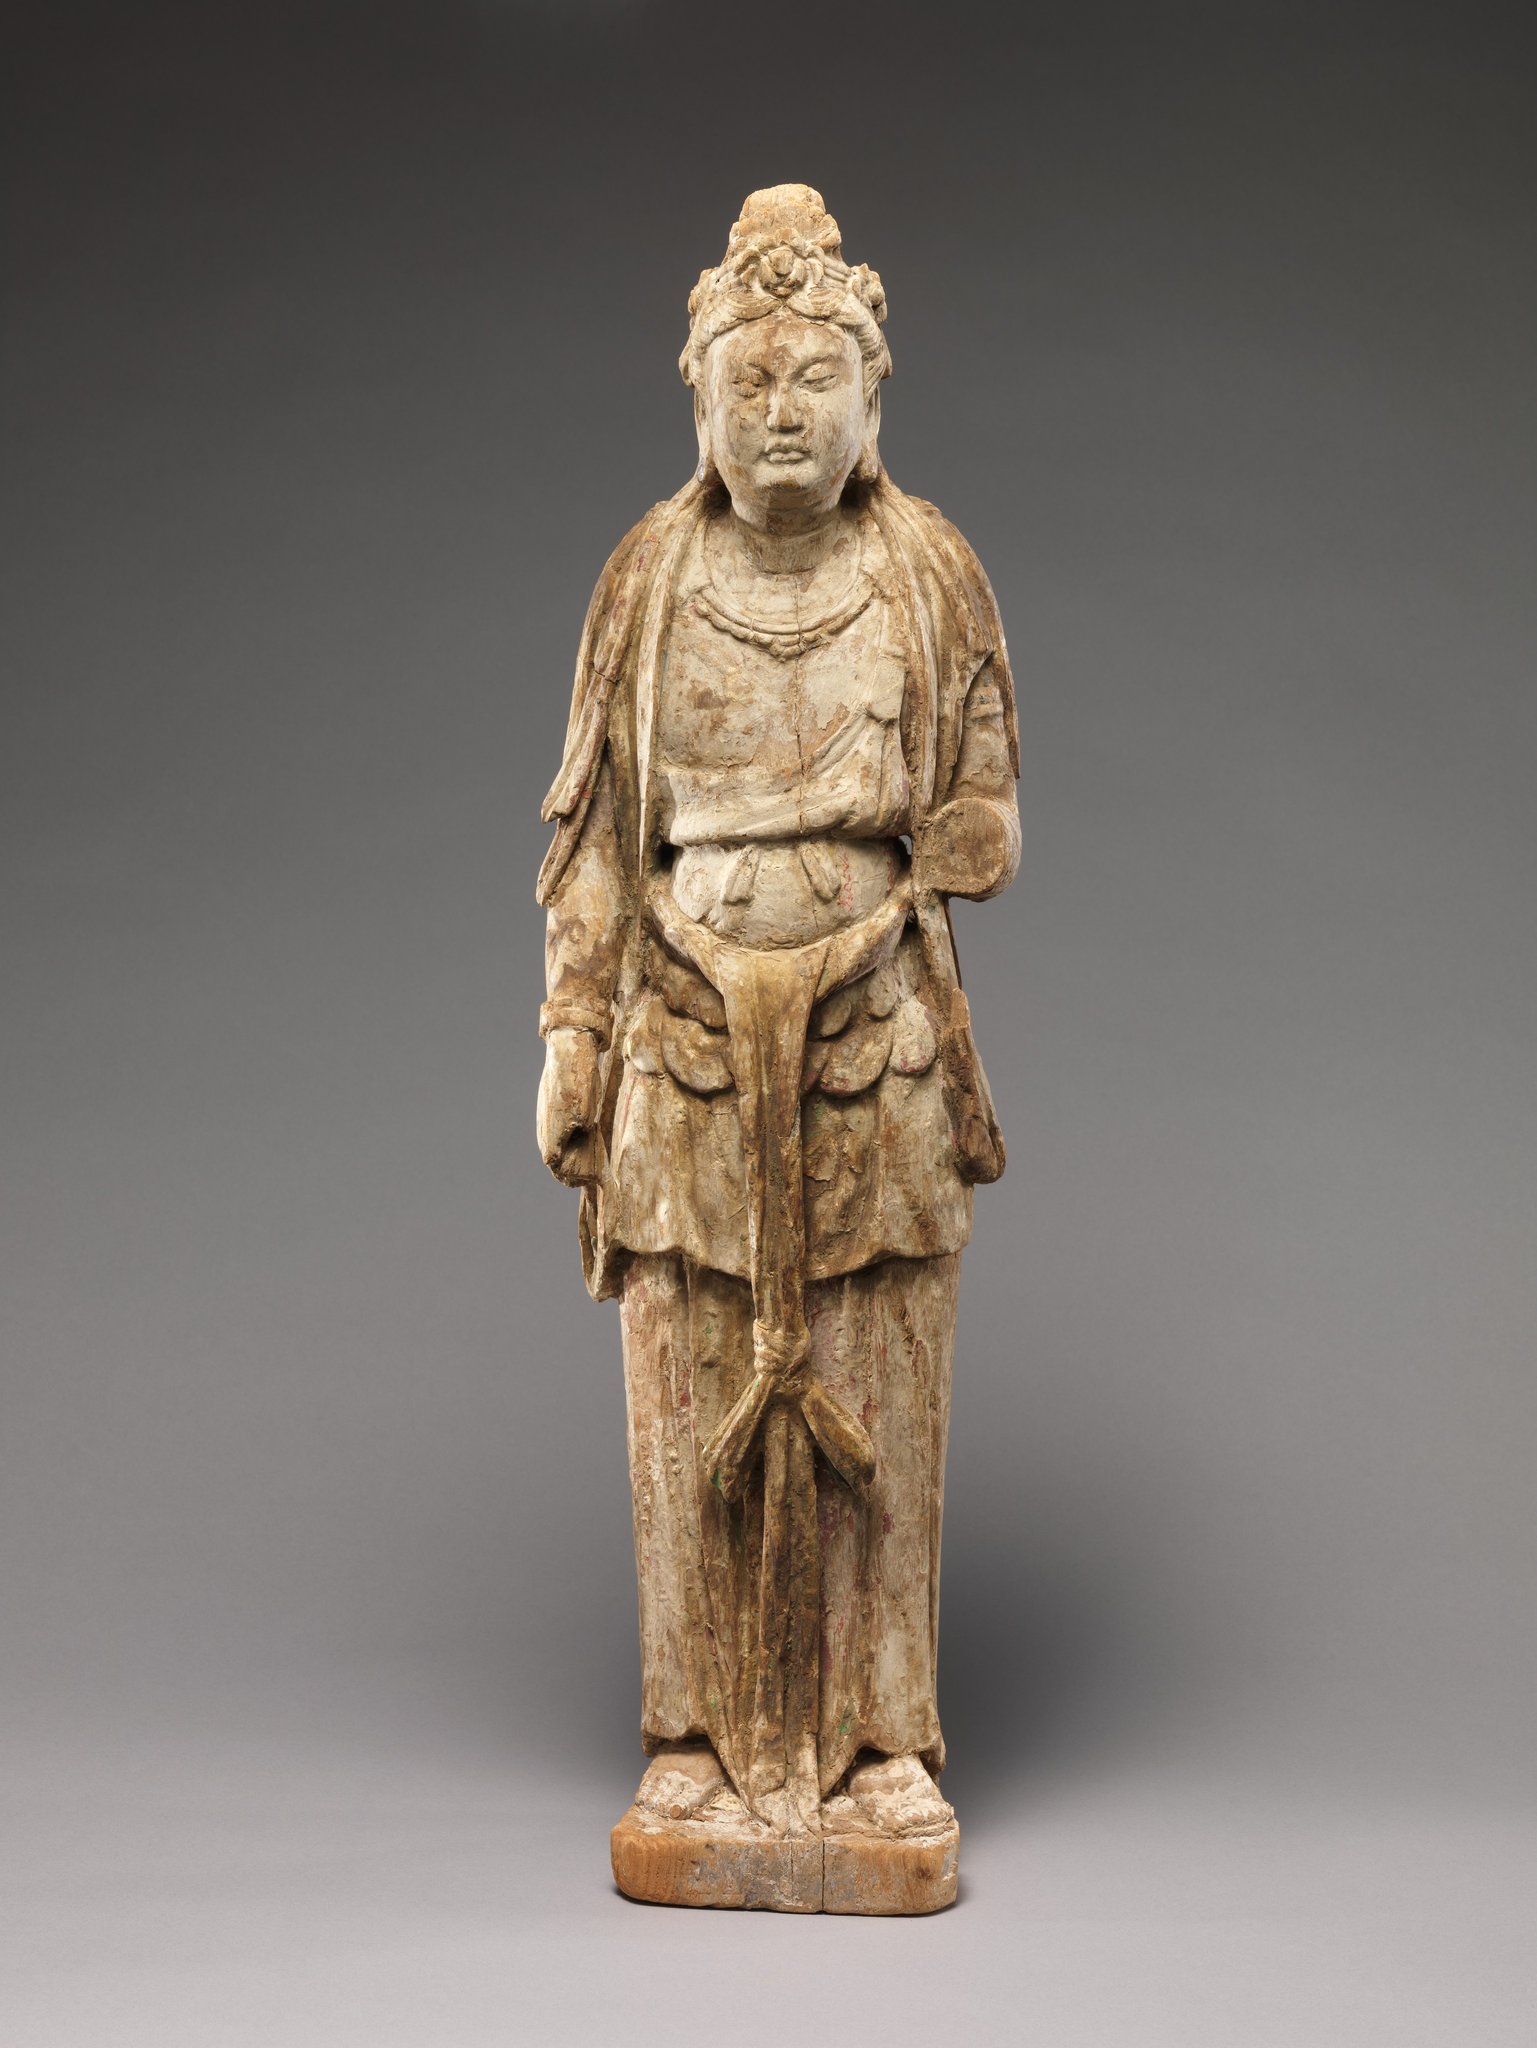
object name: figure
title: Bodhisattva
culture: chinese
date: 801-1000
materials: pigment, wood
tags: bodhisattvas